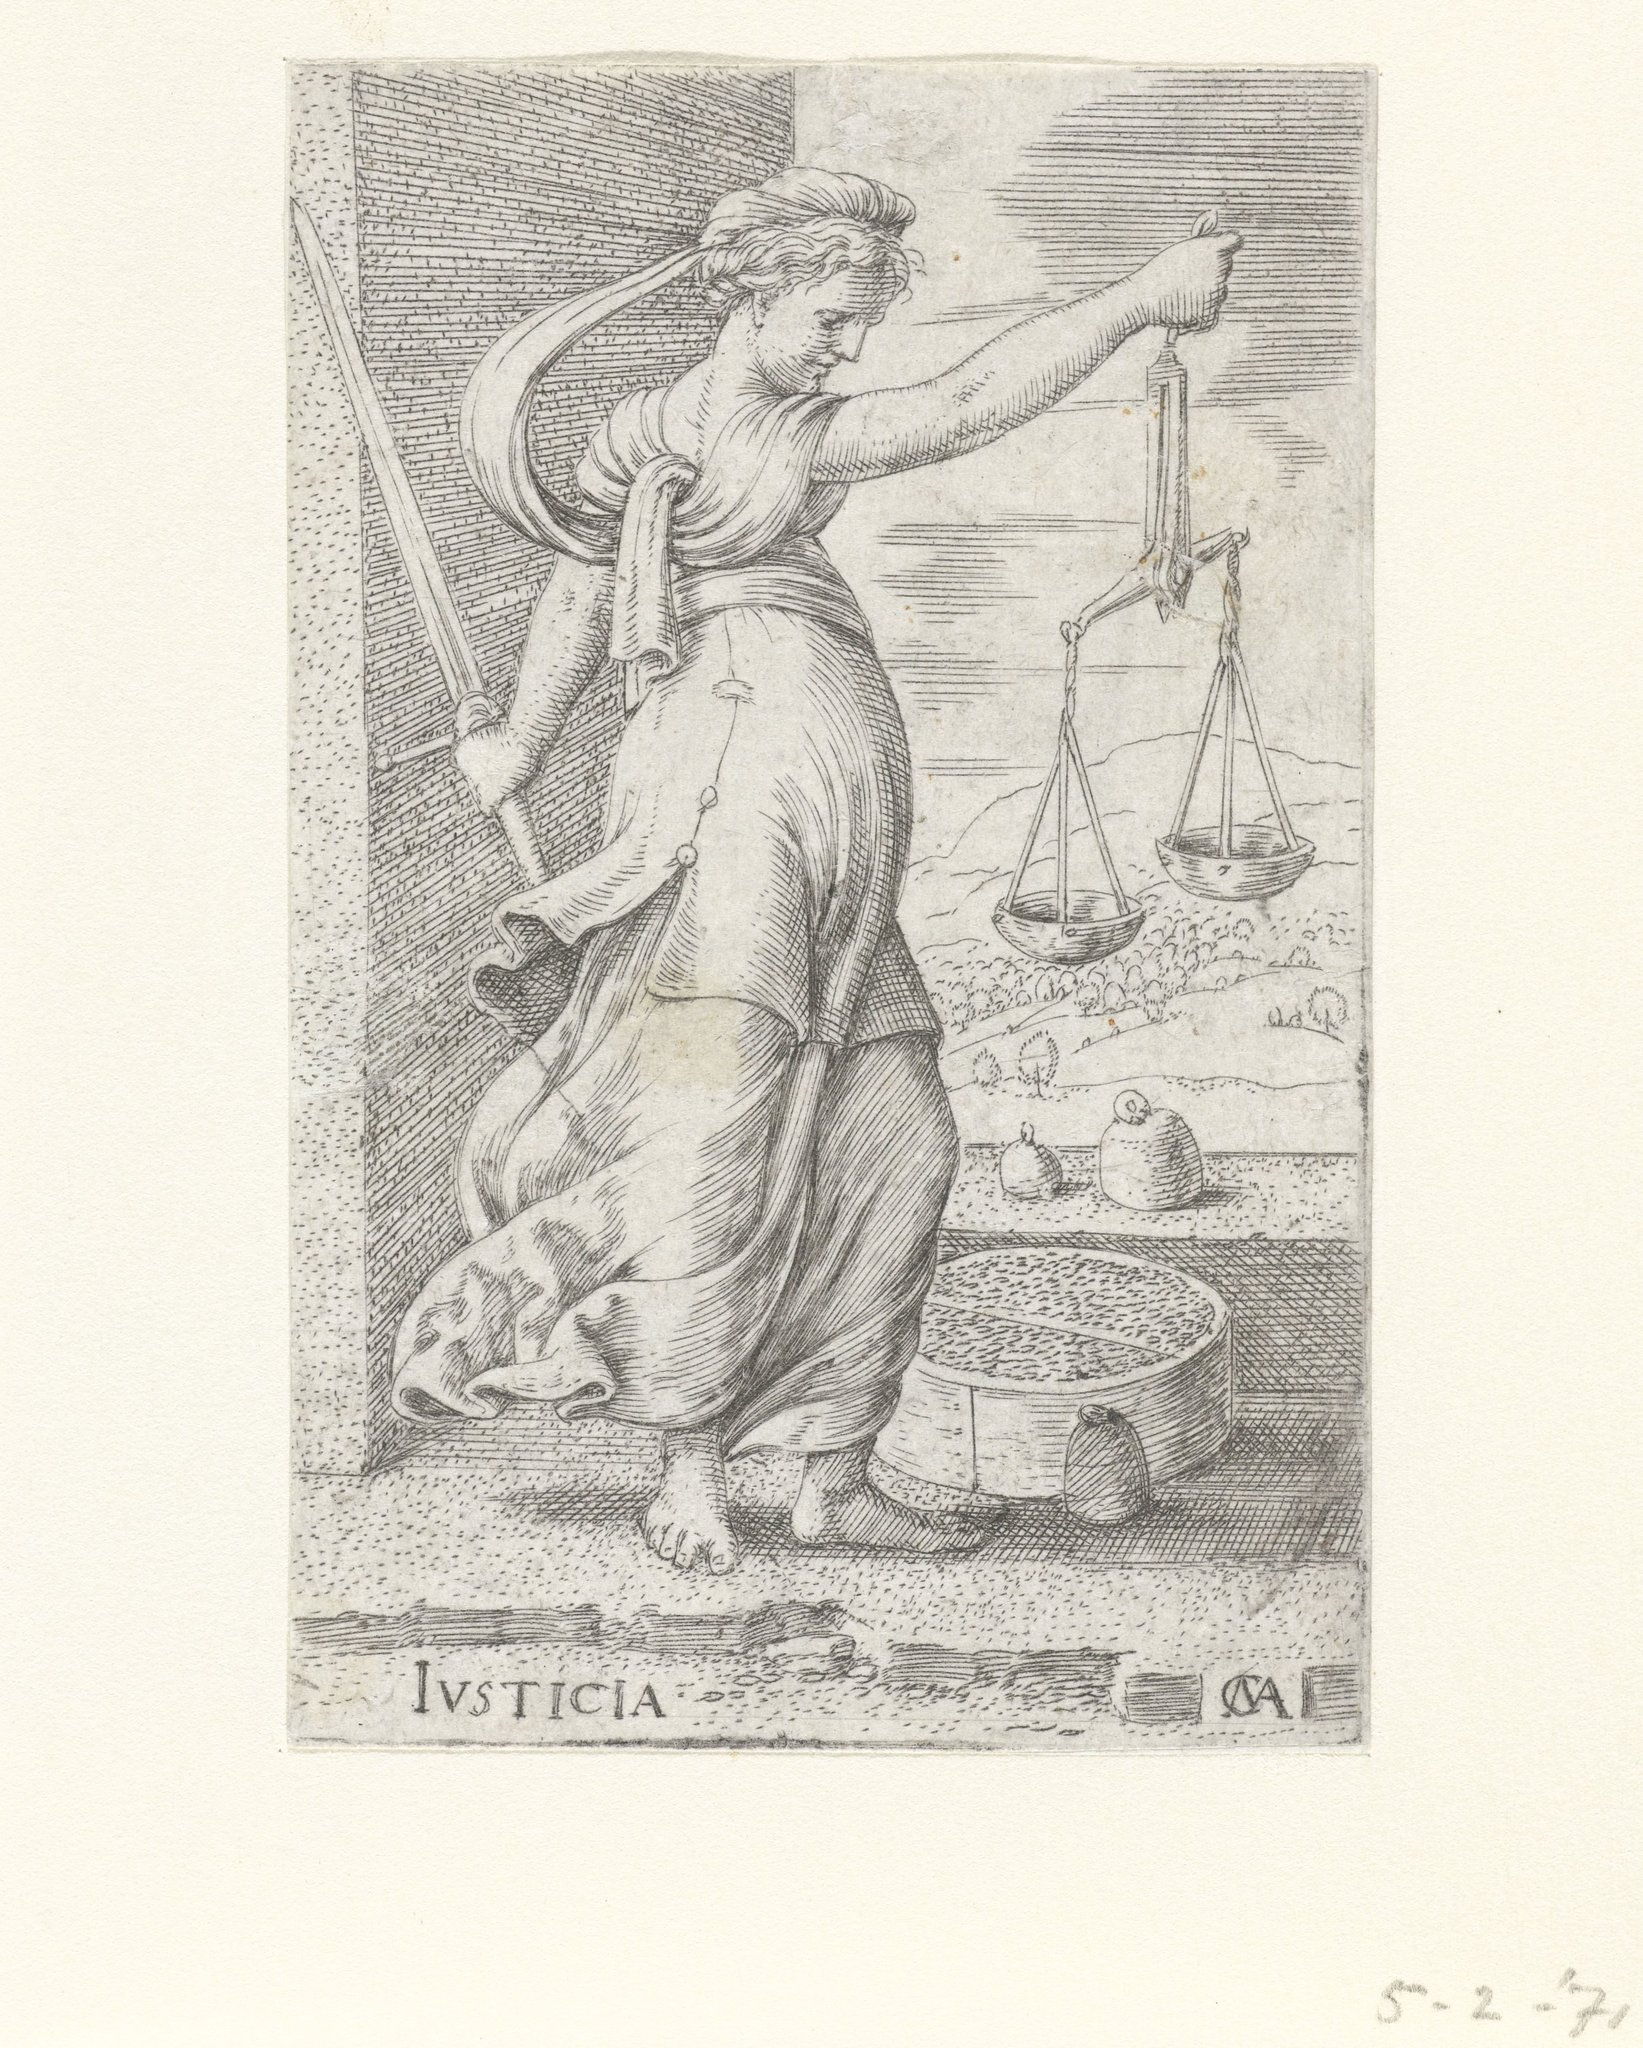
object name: print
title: Rechtvaardigheid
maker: cornelis massijs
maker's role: painter, print maker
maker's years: 1510-1557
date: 1543-1544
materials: paper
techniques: engraving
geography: antwerp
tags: justice, 'justitia'; 'giustitia divina' (ripa) ~ one of the four cardinal virtues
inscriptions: collector's mark: Lugt 2228, collector's mark: Lugt 1209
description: De personificatie van de deugd Rechtvaardigheid met de weegschaal in de ene en het zwaard in de andere hand. Aan haar voeten en op een muurtje staan gewichten. Op de achtergrond een landschap.